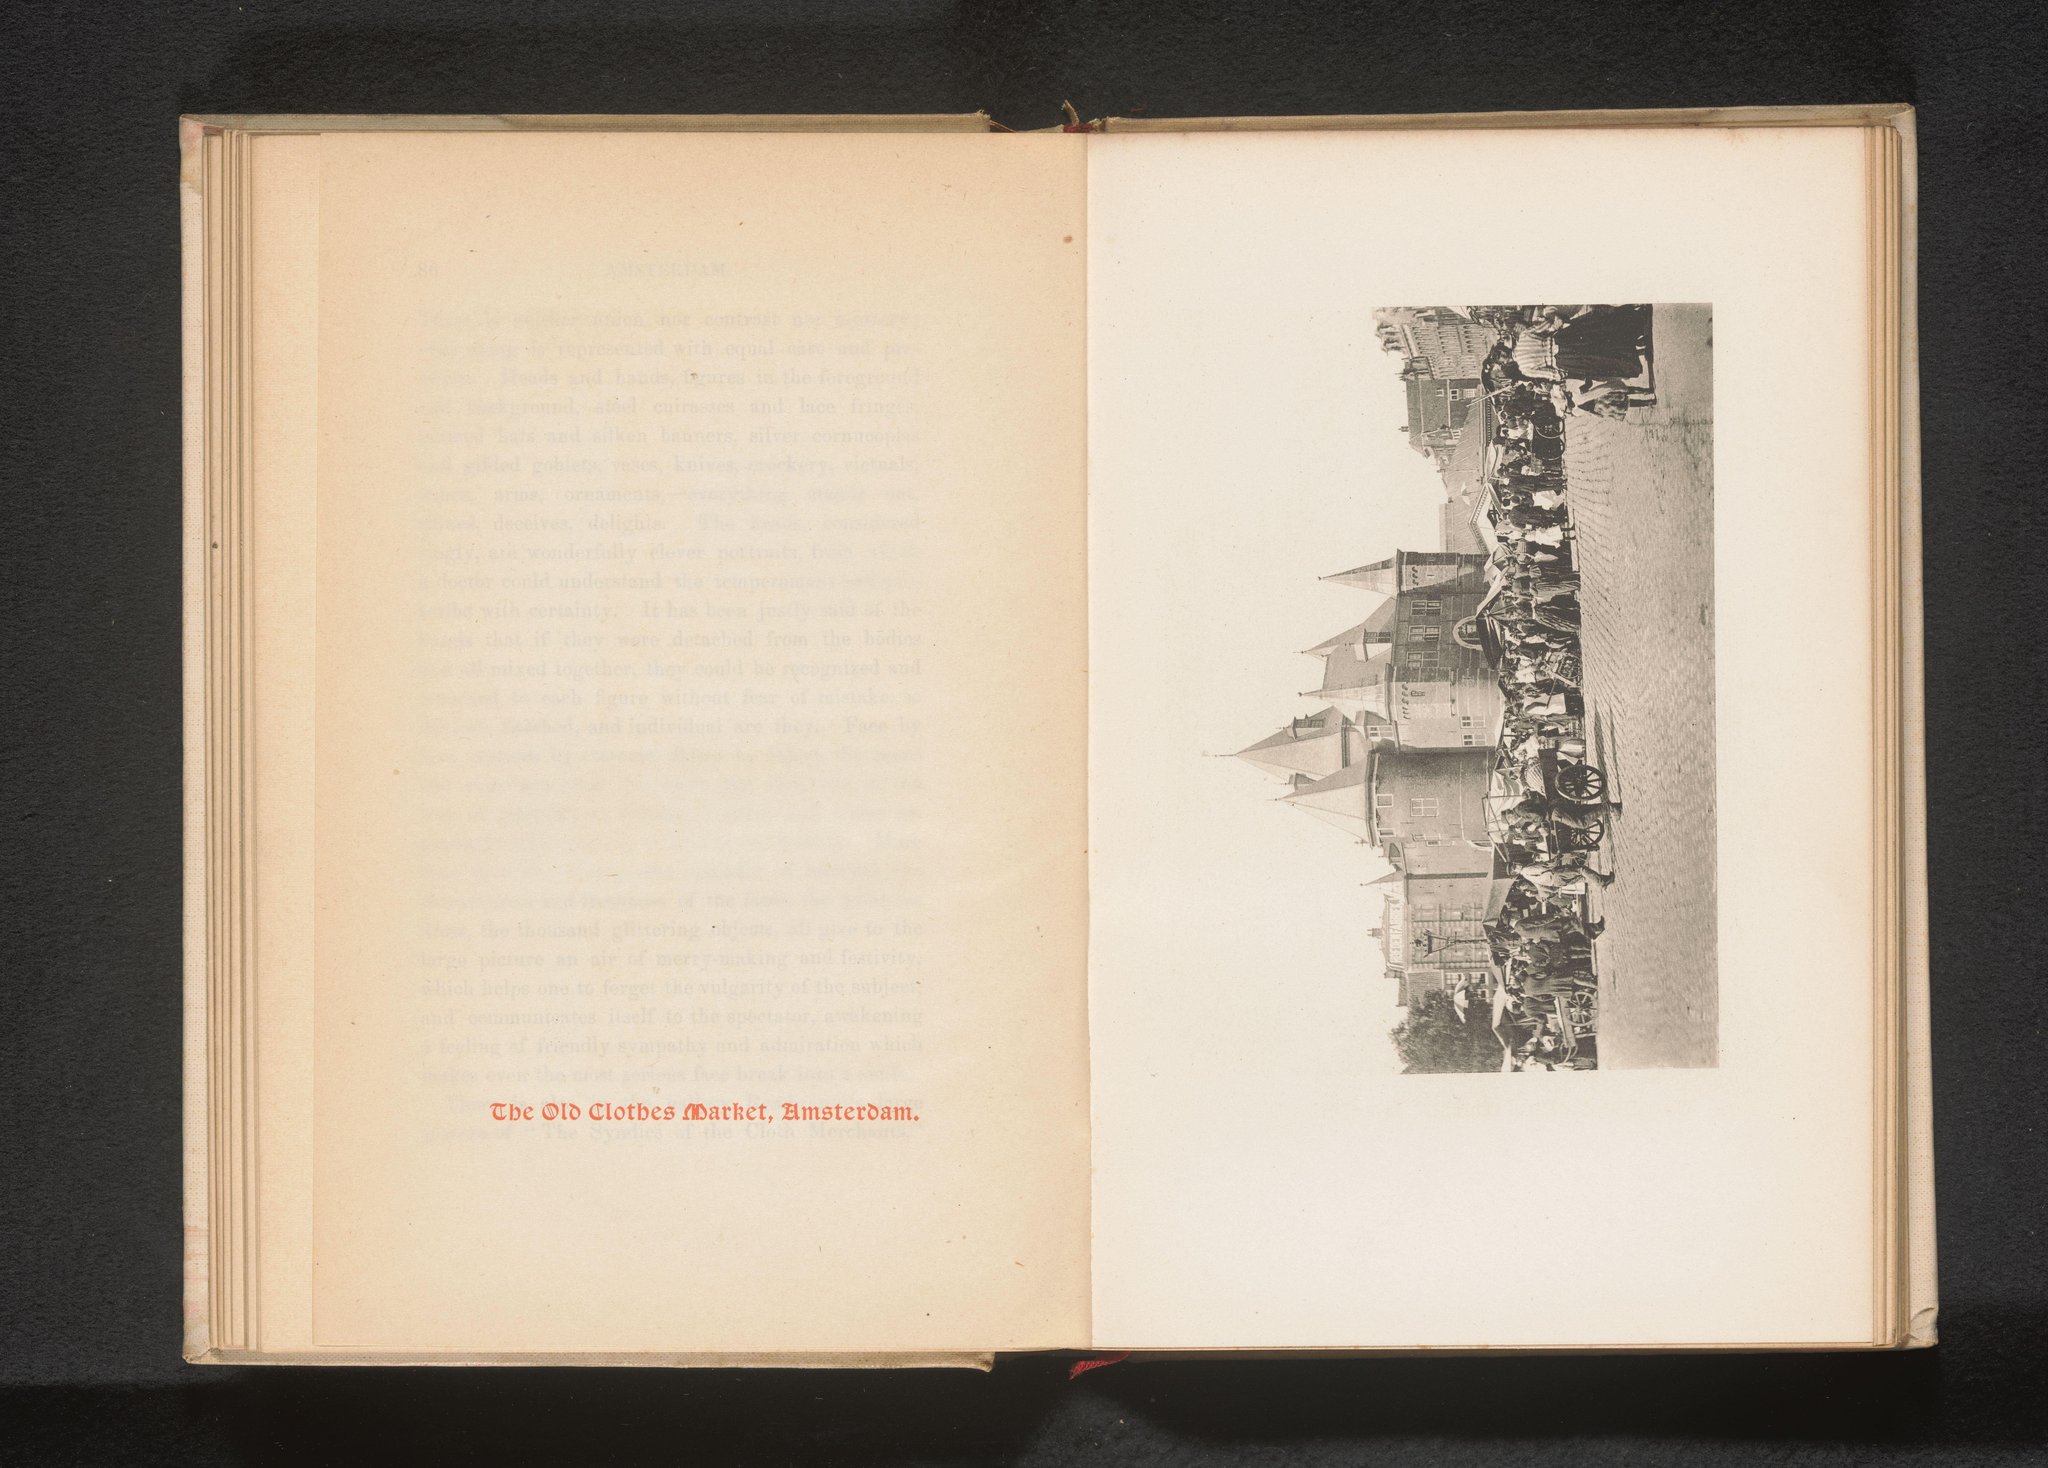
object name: photomechanical print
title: Markt op de Nieuwmarkt te Amsterdam, met op de achtergrond de Waag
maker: charles l. mitchell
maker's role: fotograaf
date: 1884-1894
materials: paper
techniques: photoaquatint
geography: nieuwmarkt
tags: market, weigh-house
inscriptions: title: ‘The Old Clothes Market, Amsterdam.’